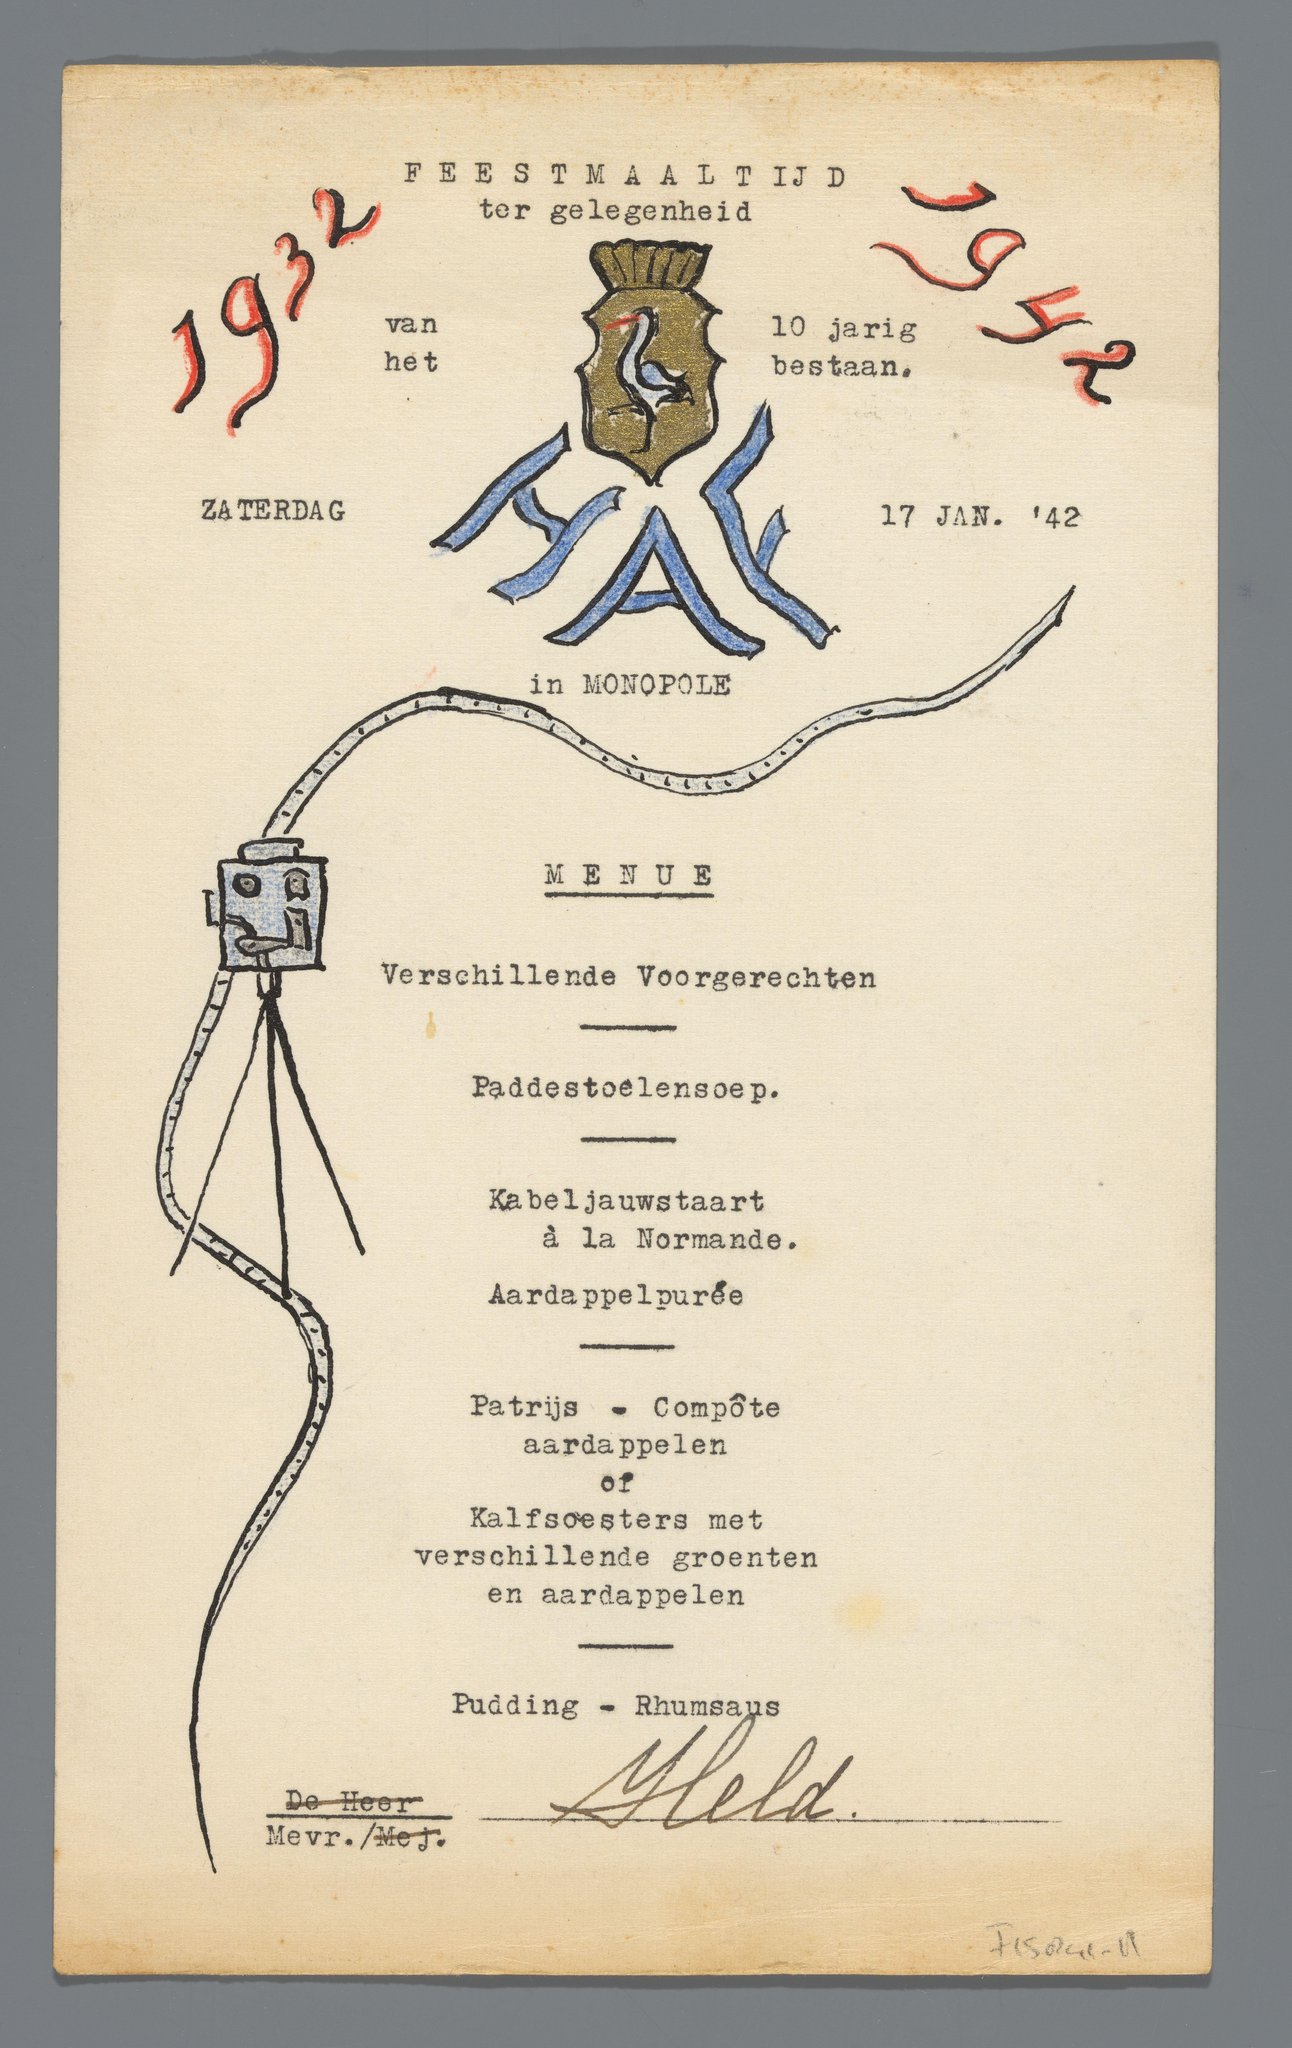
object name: menu, menukaart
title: Menukaart voor het diner ter ere van het tienjarig bestaan van de Haagse Amateur Filmclub (HAF)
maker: Anonymous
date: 1942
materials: paint, ink, paper, pencil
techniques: drawing, pen, typewriting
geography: the hague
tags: film camera, movie camera, video camera, the hague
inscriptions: signature: ‘(...)’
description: Versierd met getekende filmcamera en een rol film. De kaart is gesigneerd door de gasten.